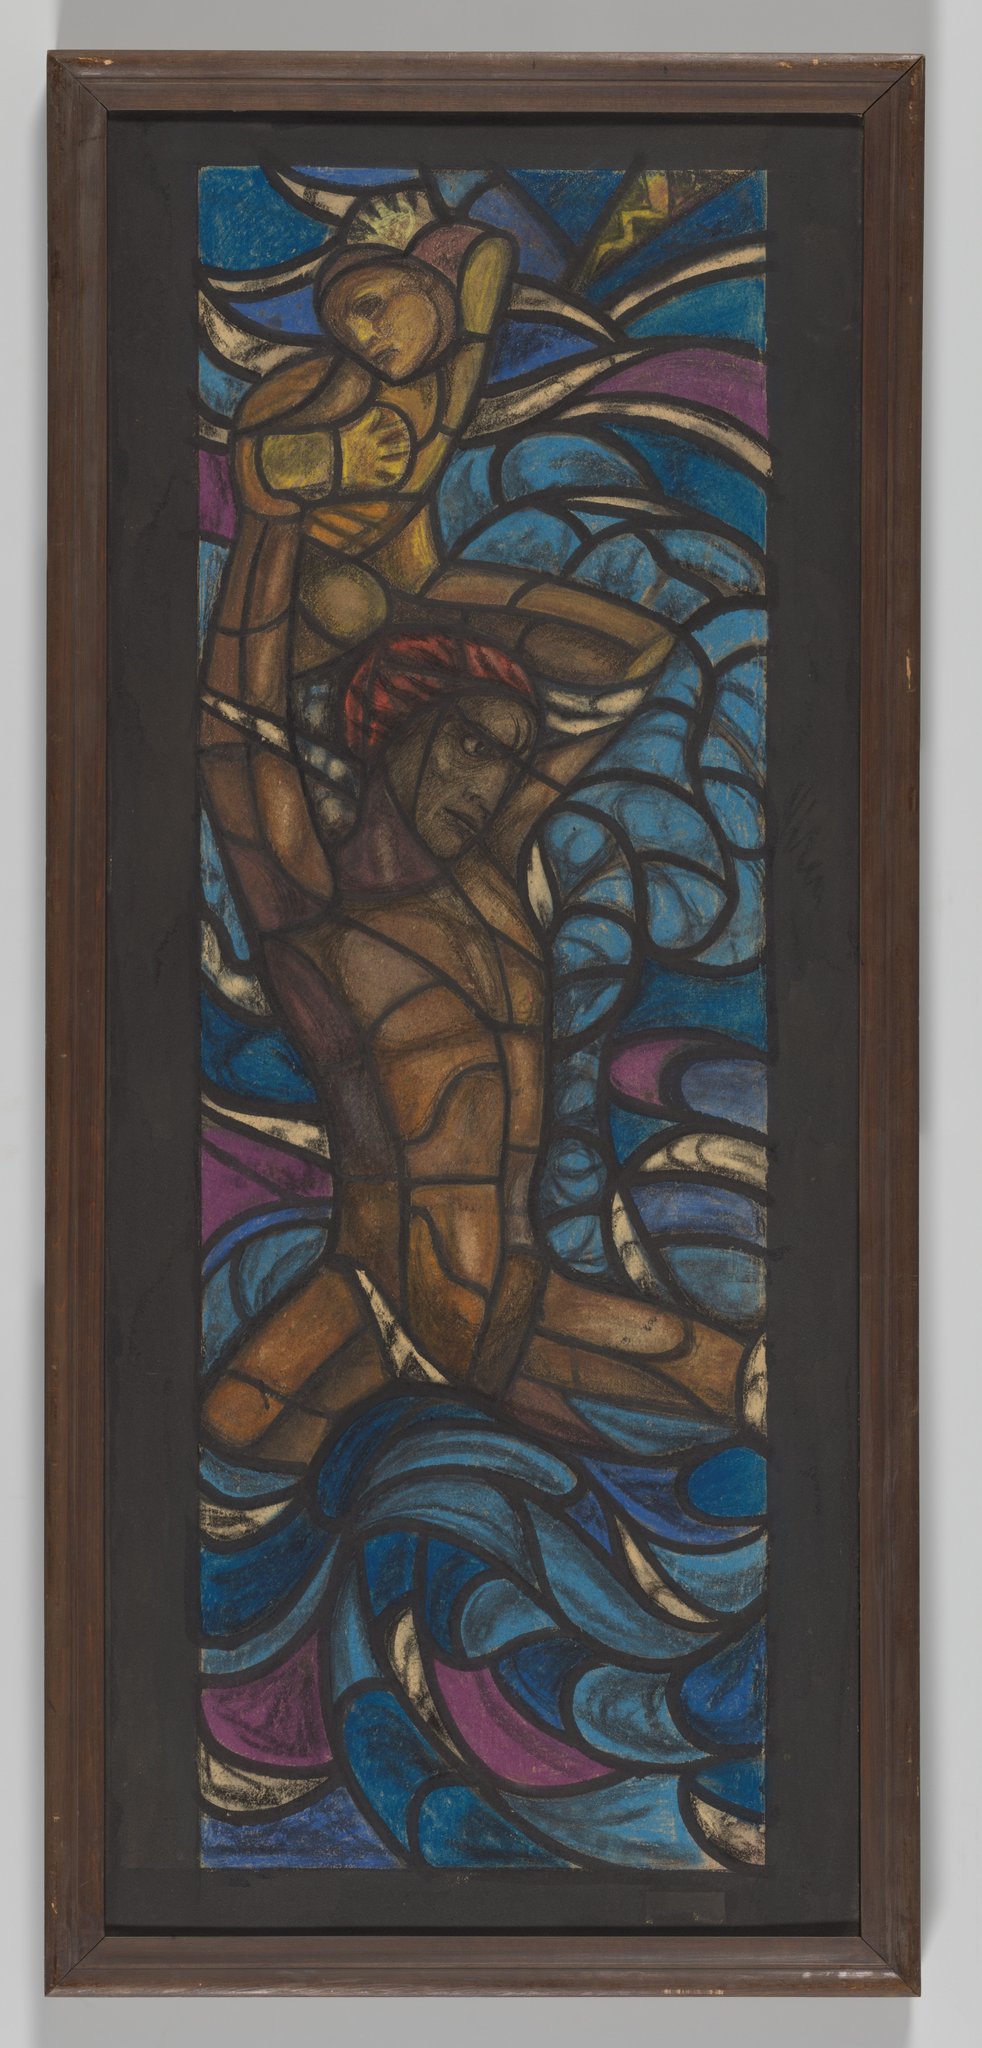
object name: design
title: Ontwerp voor raam in het Amsterdams Lyceum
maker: richard nicolaüs roland holst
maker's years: 1868-1938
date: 1927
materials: cardboard, chalk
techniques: brush